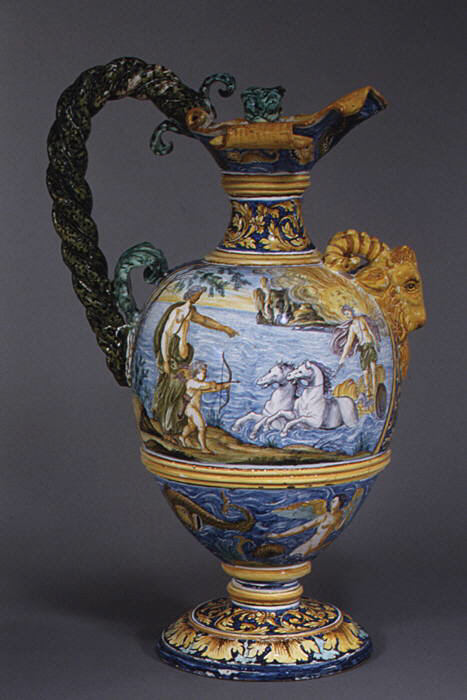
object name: wine jug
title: Wine jug (one of a pair)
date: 1680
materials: faience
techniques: glazing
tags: cupid,horses,chariots